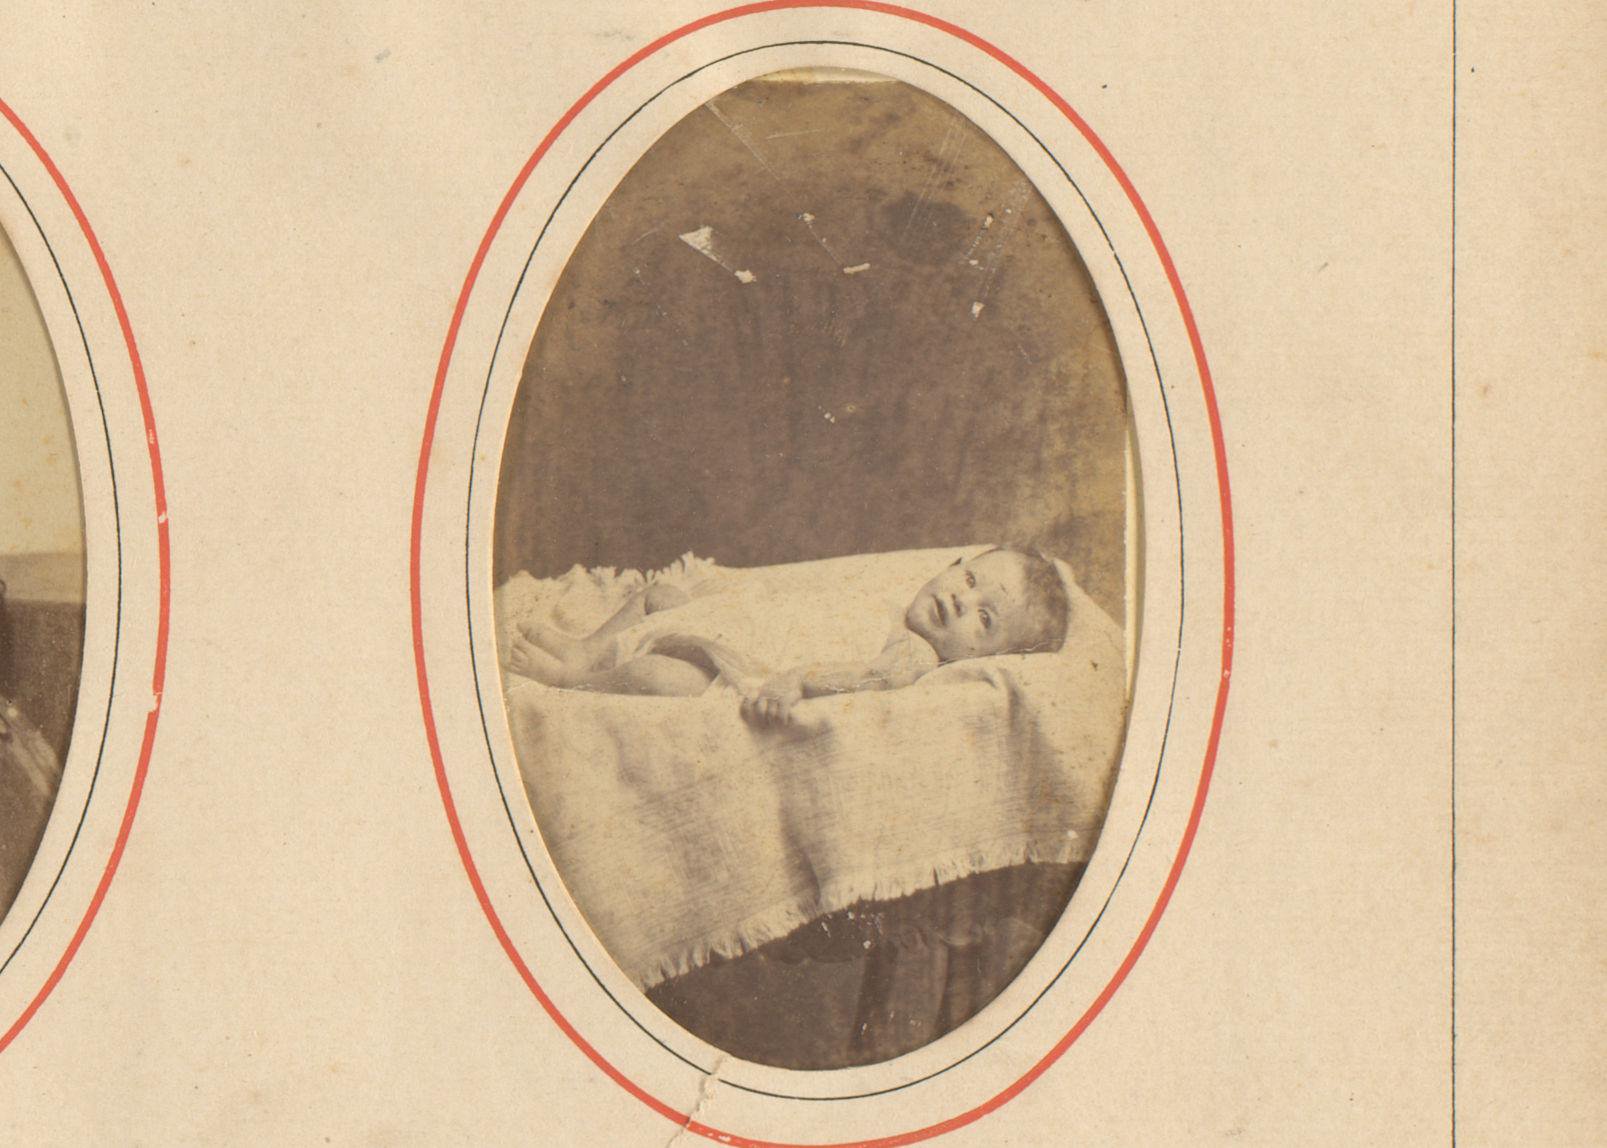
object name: carte de visite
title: Portret van een onbekende baby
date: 1871-1890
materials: cardboard, paper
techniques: albumen print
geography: batavia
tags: anonymous historical person portrayed